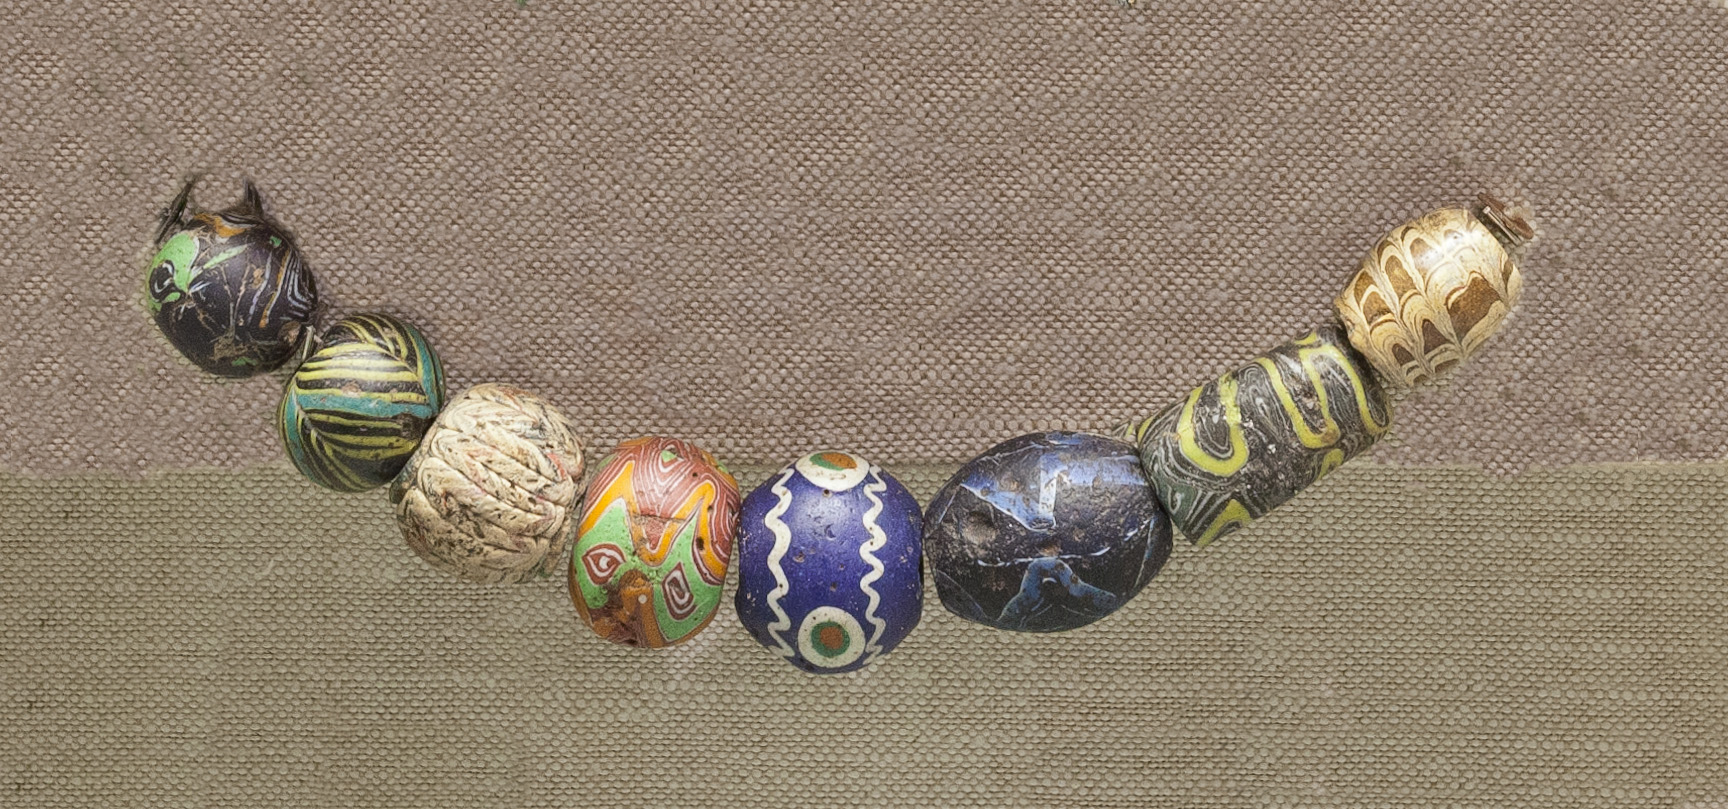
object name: bead, string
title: String of 8 Beads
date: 600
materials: glass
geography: egypt